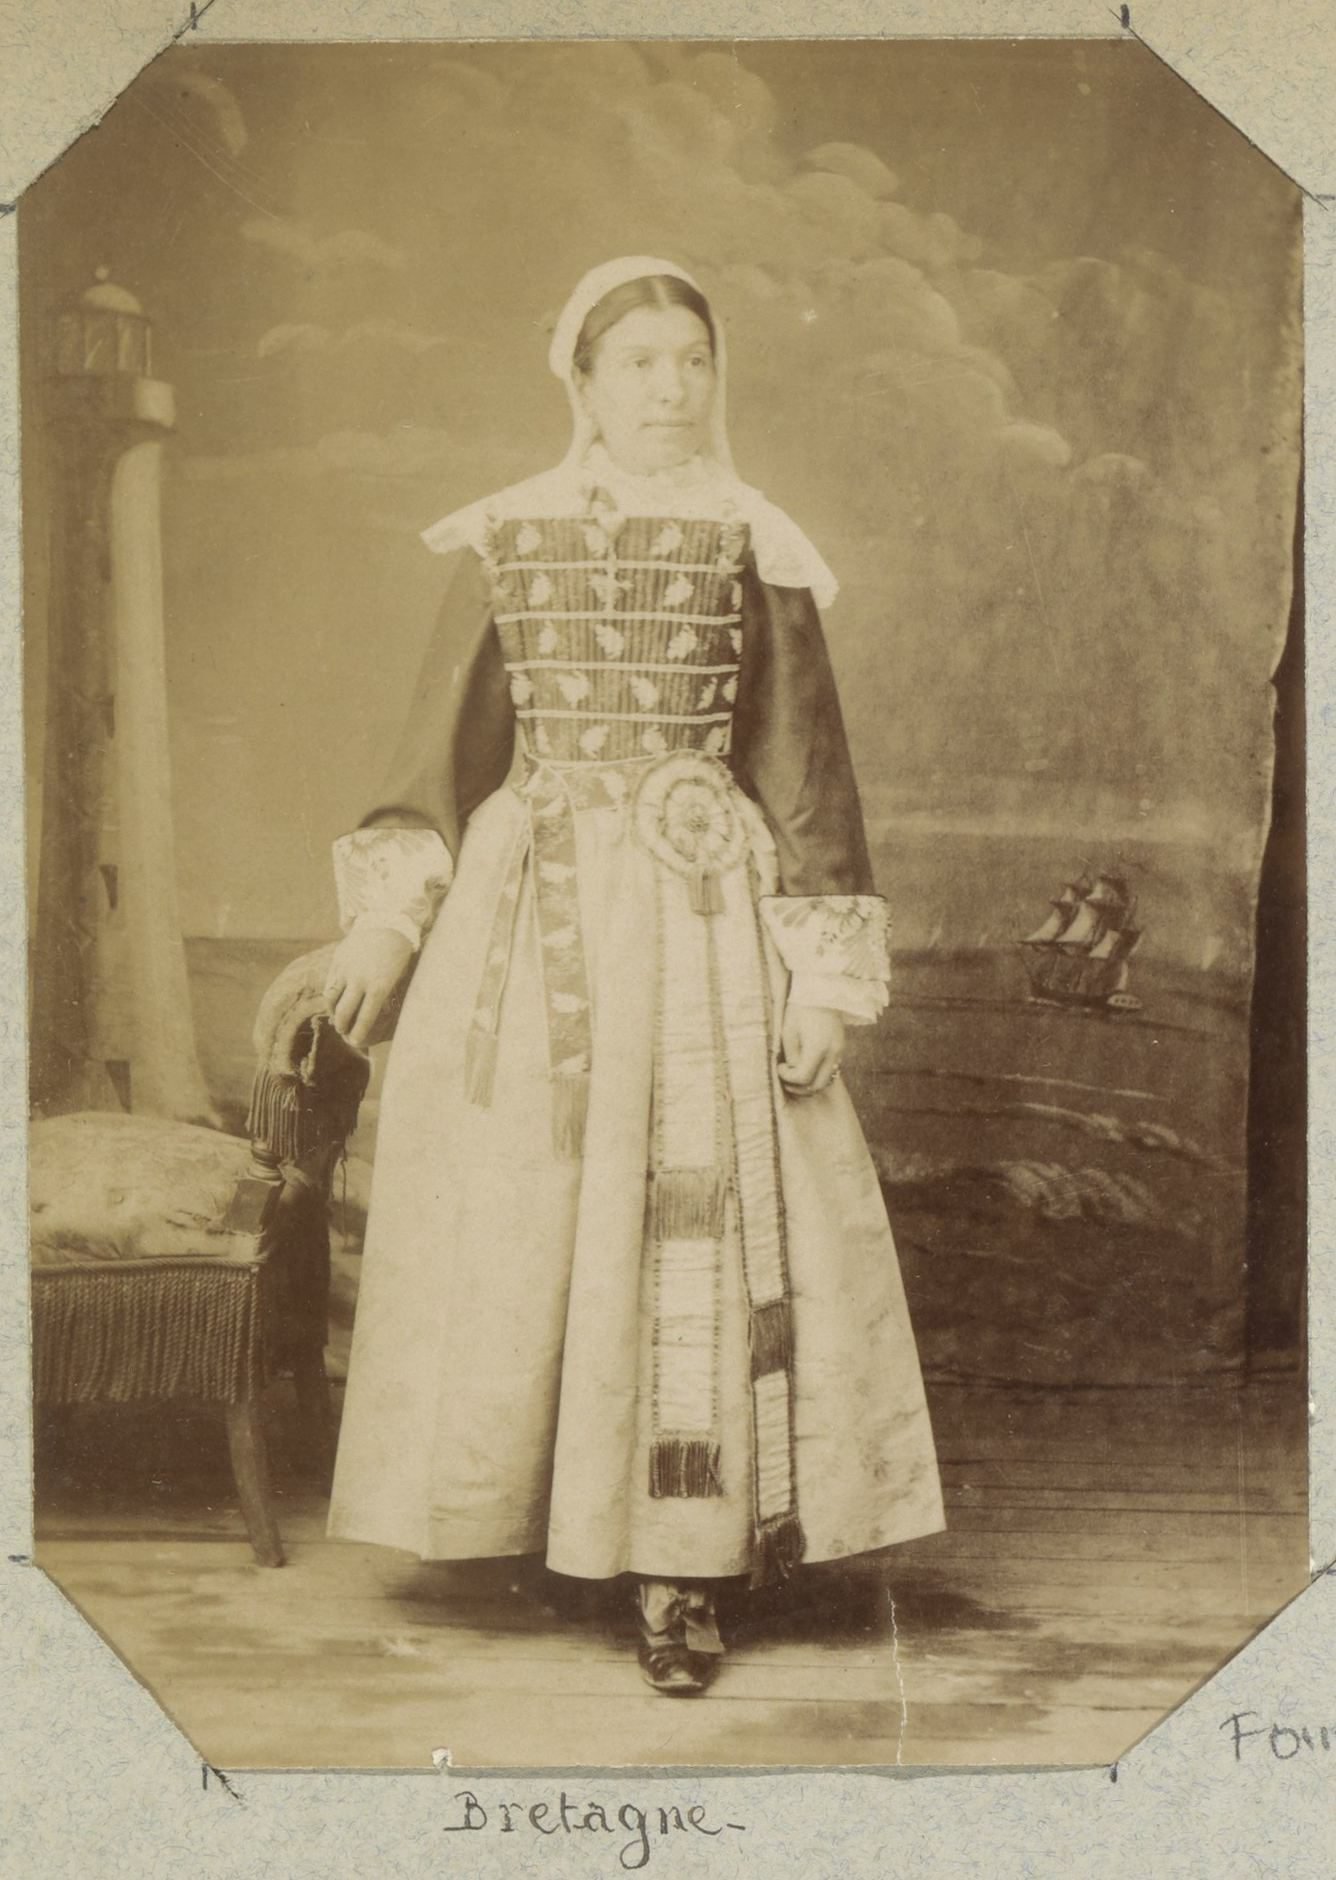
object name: photograph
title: Portret van een vrouw in klederdracht uit Bourg de Batz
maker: Anonymous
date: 1890-1900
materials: paper, photographic support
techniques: albumen print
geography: brittany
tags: folk costume, regional costume (+ women's clothes), adult woman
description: Waarschijnlijk gaat het hier om kostuums geïnspireerd op daadwerkelijke klederdracht uit Bourg de Batz. Toeristen lieten zich aan het eind van de 19e eeuw in dergelijke kostuums fotograferen bij een bezoek aan de badplaats.